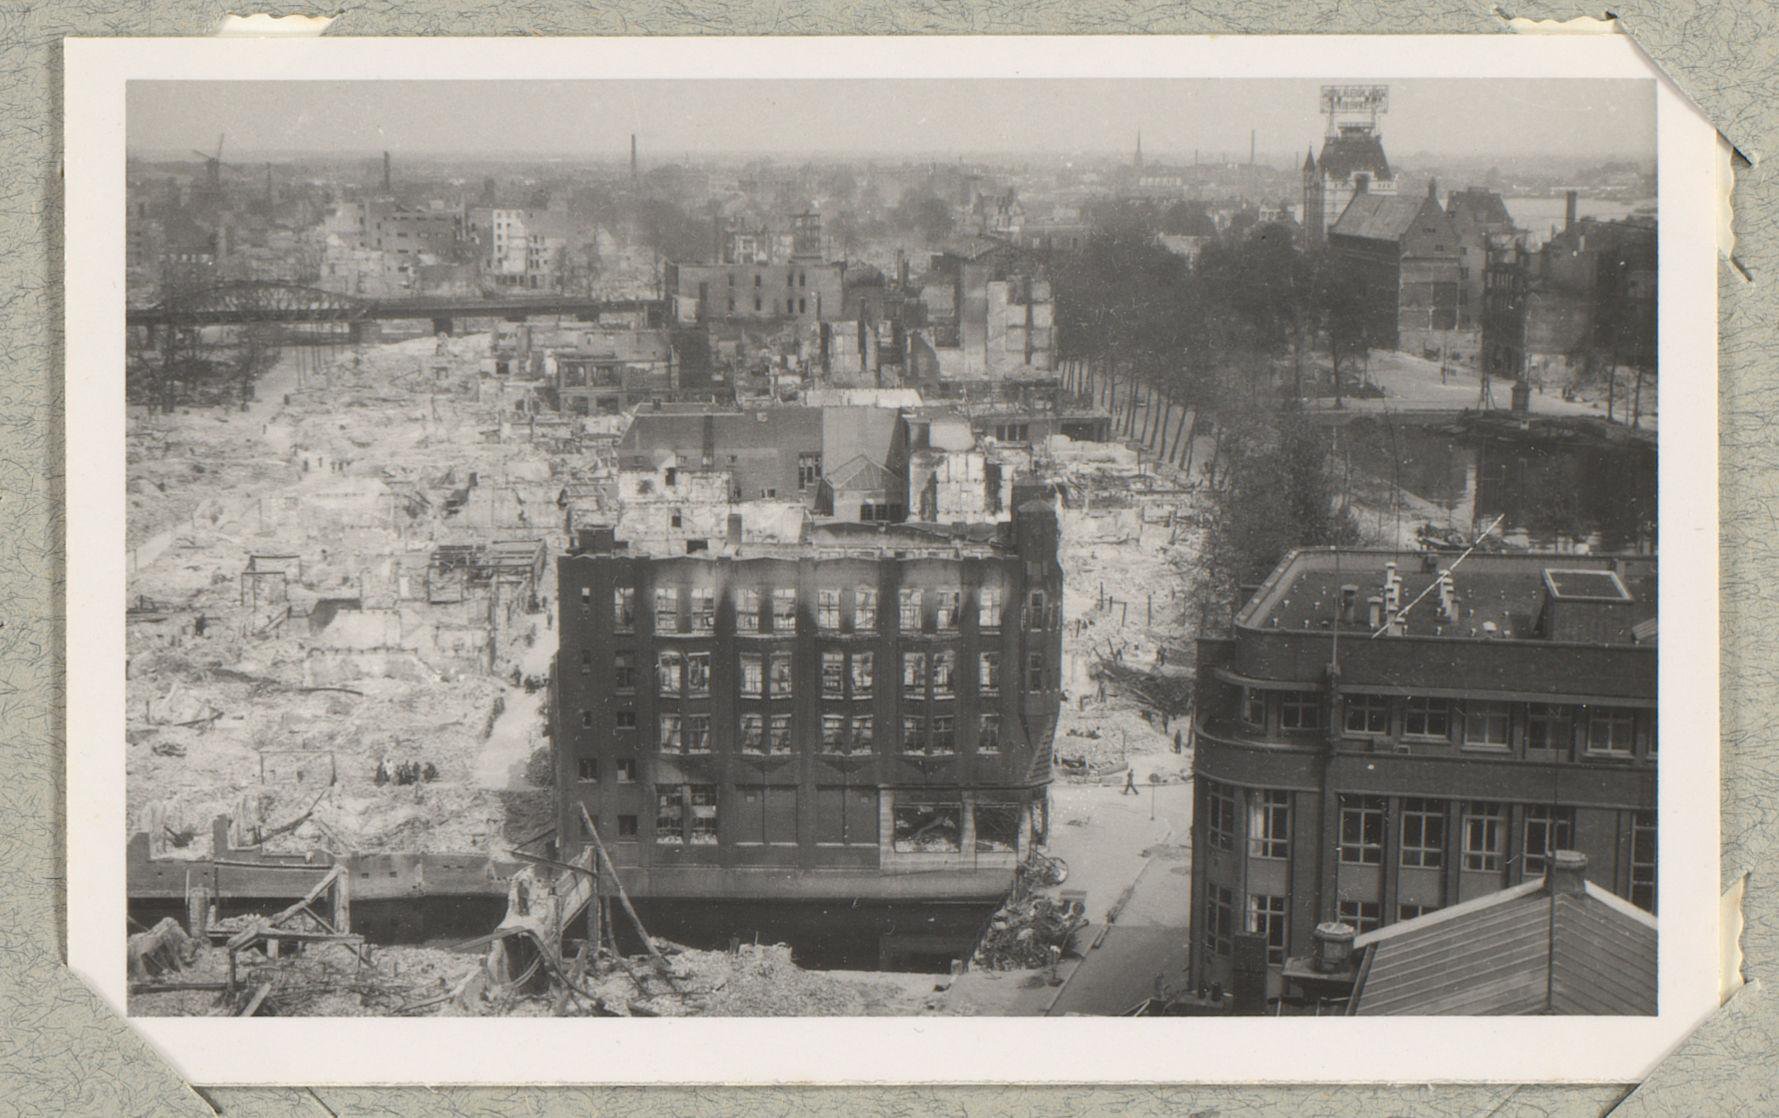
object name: photograph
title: Ruïnes bij het Steiger, de Soetensteeg, Noord-Blaak te Rotterdam met Beursplein op de achtergrond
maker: j. nolte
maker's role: fotograaf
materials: photographic support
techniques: gelatin silver print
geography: rotterdam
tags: city-view in general; 'veduta', devastated, ruined place or city (~ warfare), rotterdam, rotterdam blitz